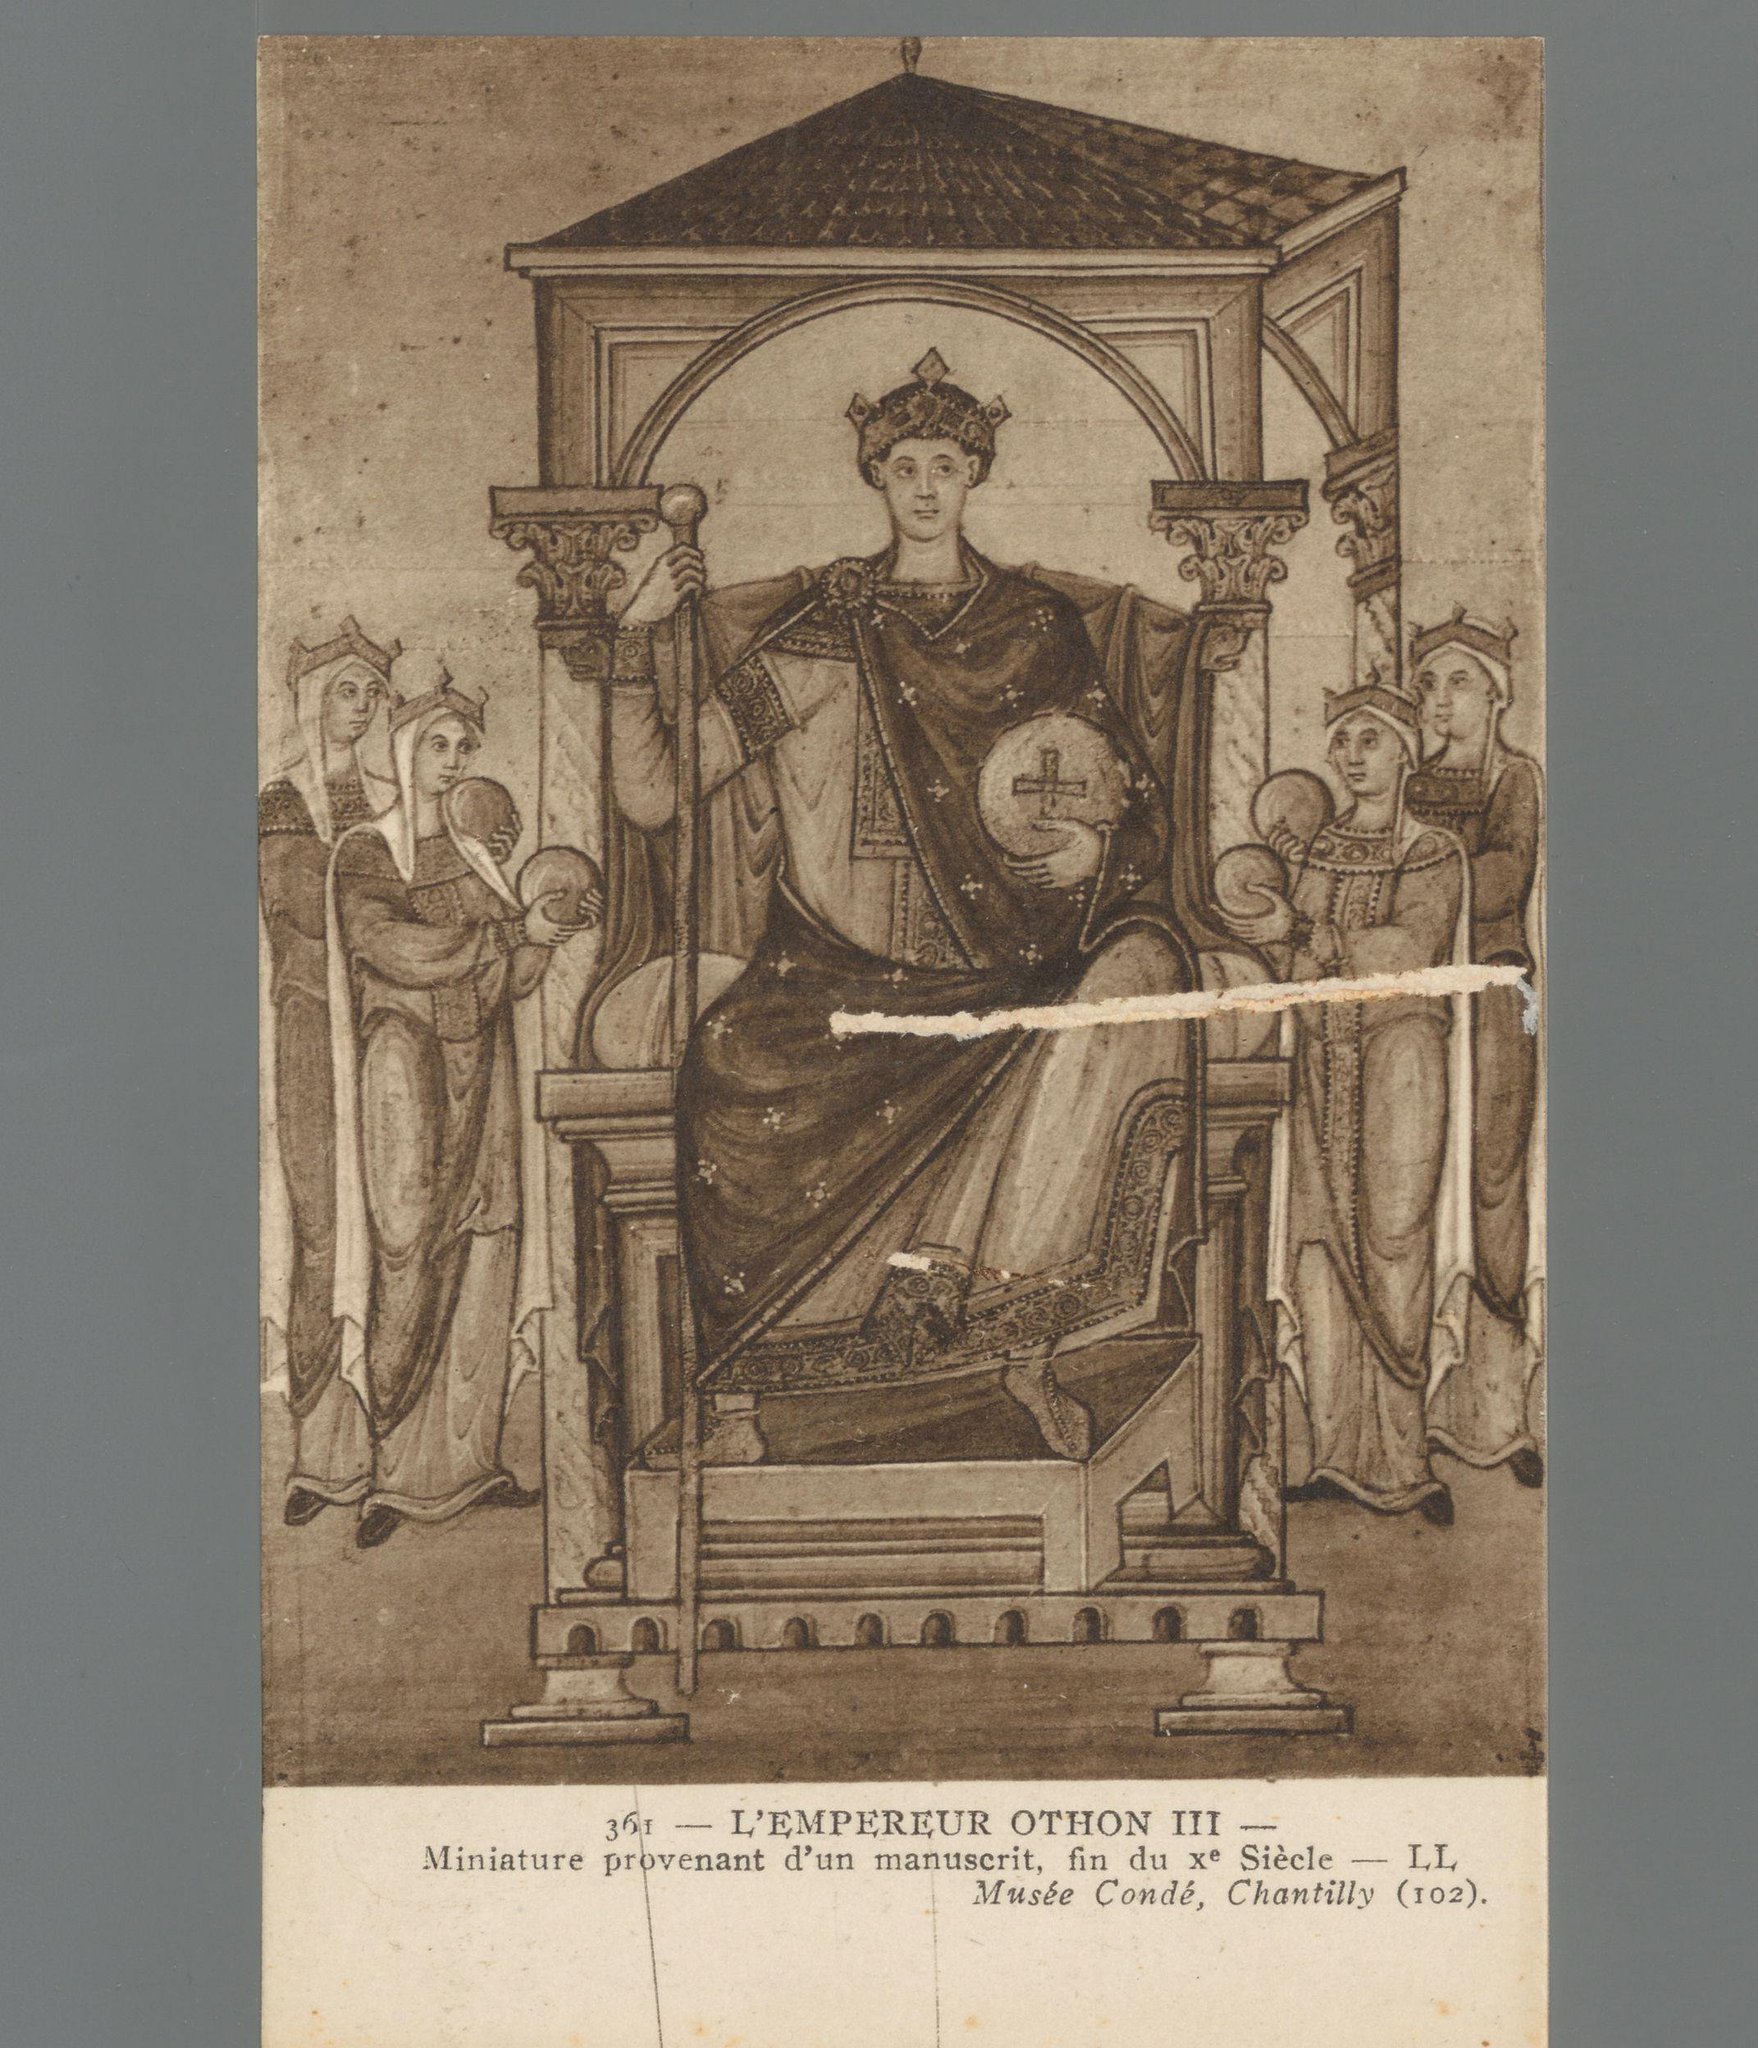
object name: reproduction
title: L'empereur Othon III - Miniature provenant d'un manuscrit, fin du Xe Siècle - Musée Condé, Chantilly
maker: Anonymous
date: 1903-1932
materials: cardboard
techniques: photograph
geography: paris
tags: emperor, permanent exhibition, museum, picture, painting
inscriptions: collector's mark: ‘AFE v S’